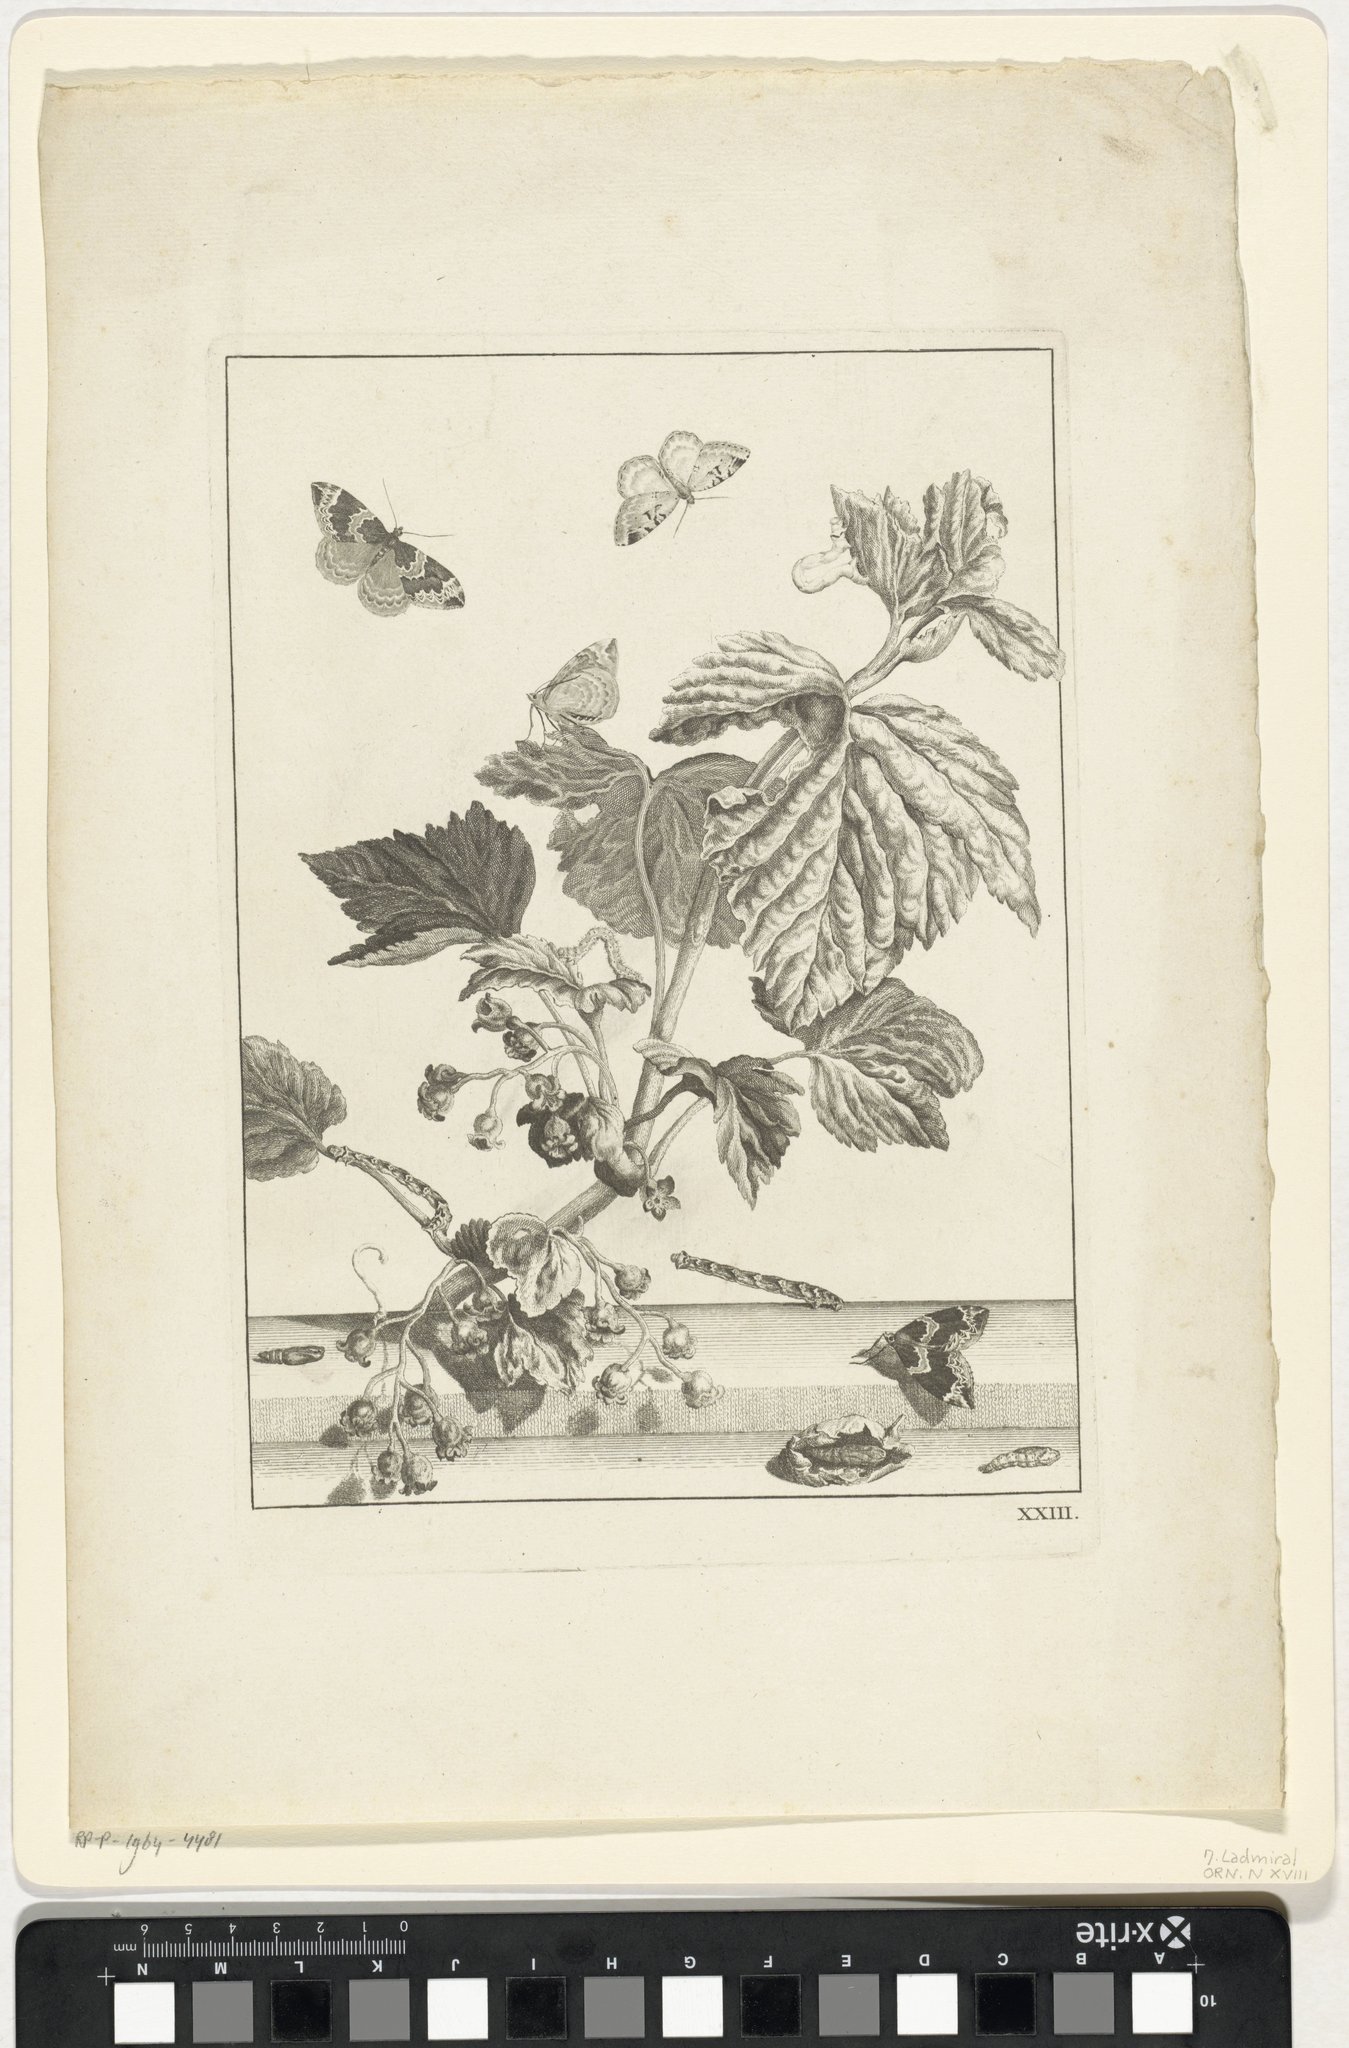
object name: book illustration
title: Vlinders op gebladerte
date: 1710-1770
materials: paper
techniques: etching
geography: amsterdam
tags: insects: butterfly, insects: caterpillar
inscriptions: collector's mark: Lugt 2760, collector's mark: Lugt 2228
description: Prent gebruikt in: L'Admiral, Jacob. Naauwkeurige waarneemingen omtrent de veranderingen van veele insekten of gekorvene diertjes. Amsterdam: Johannes Sluyter, 1774.